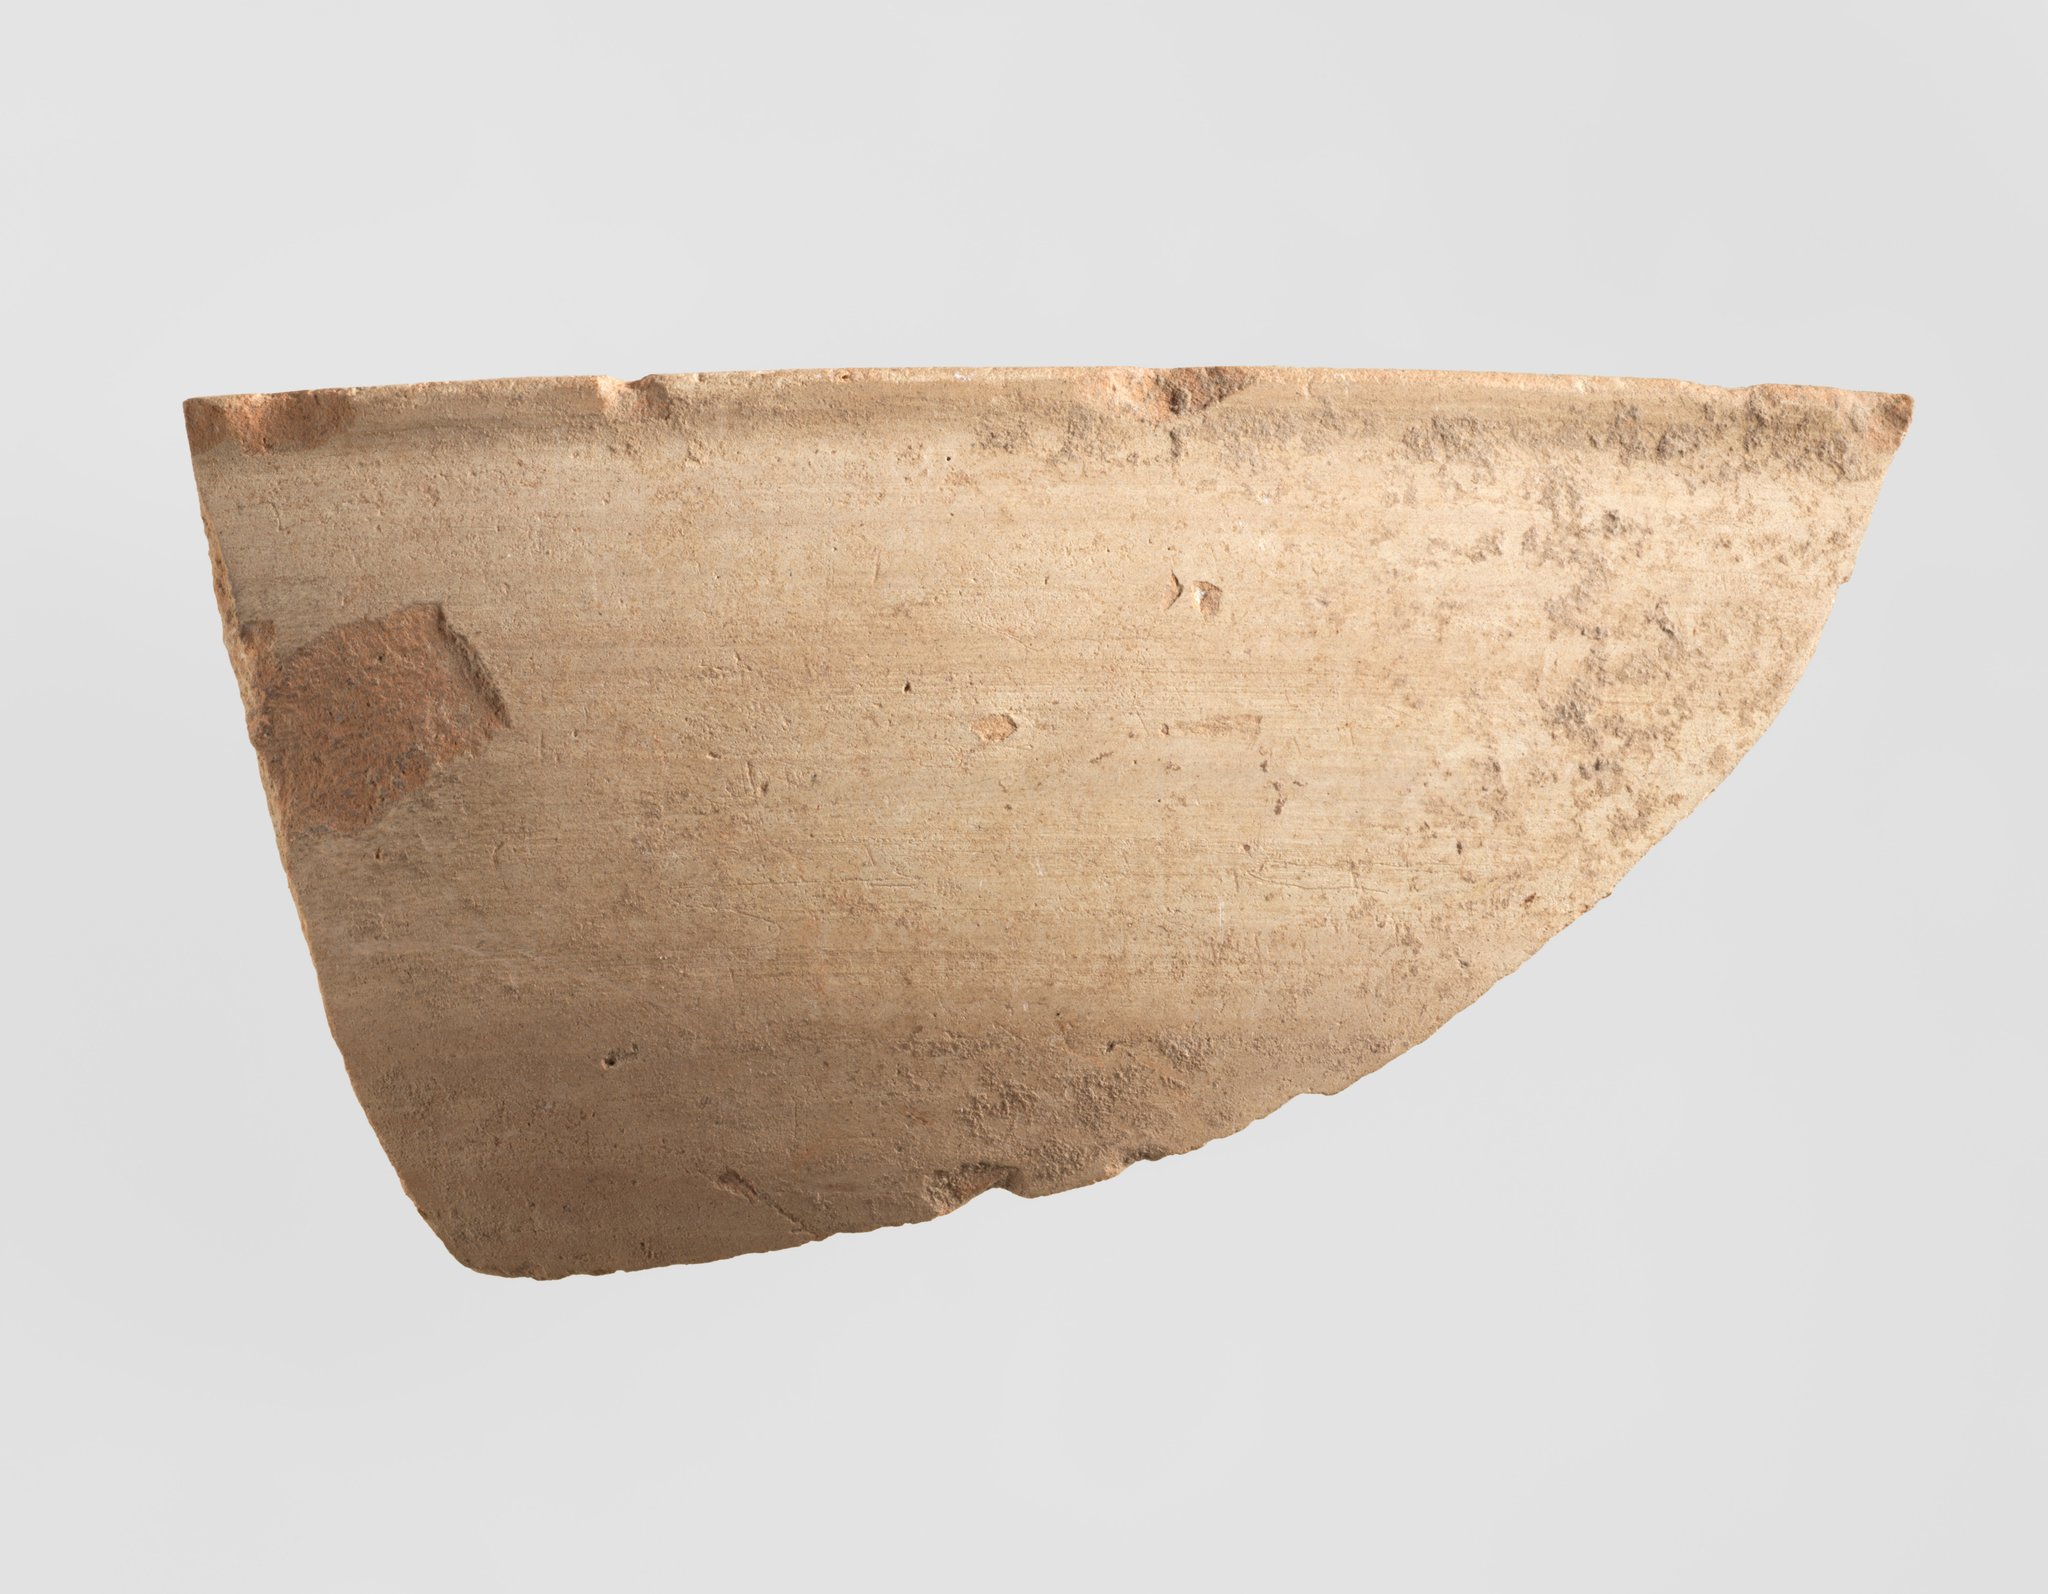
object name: sherd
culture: iranian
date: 2500-1750 BCE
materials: ceramic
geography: iran